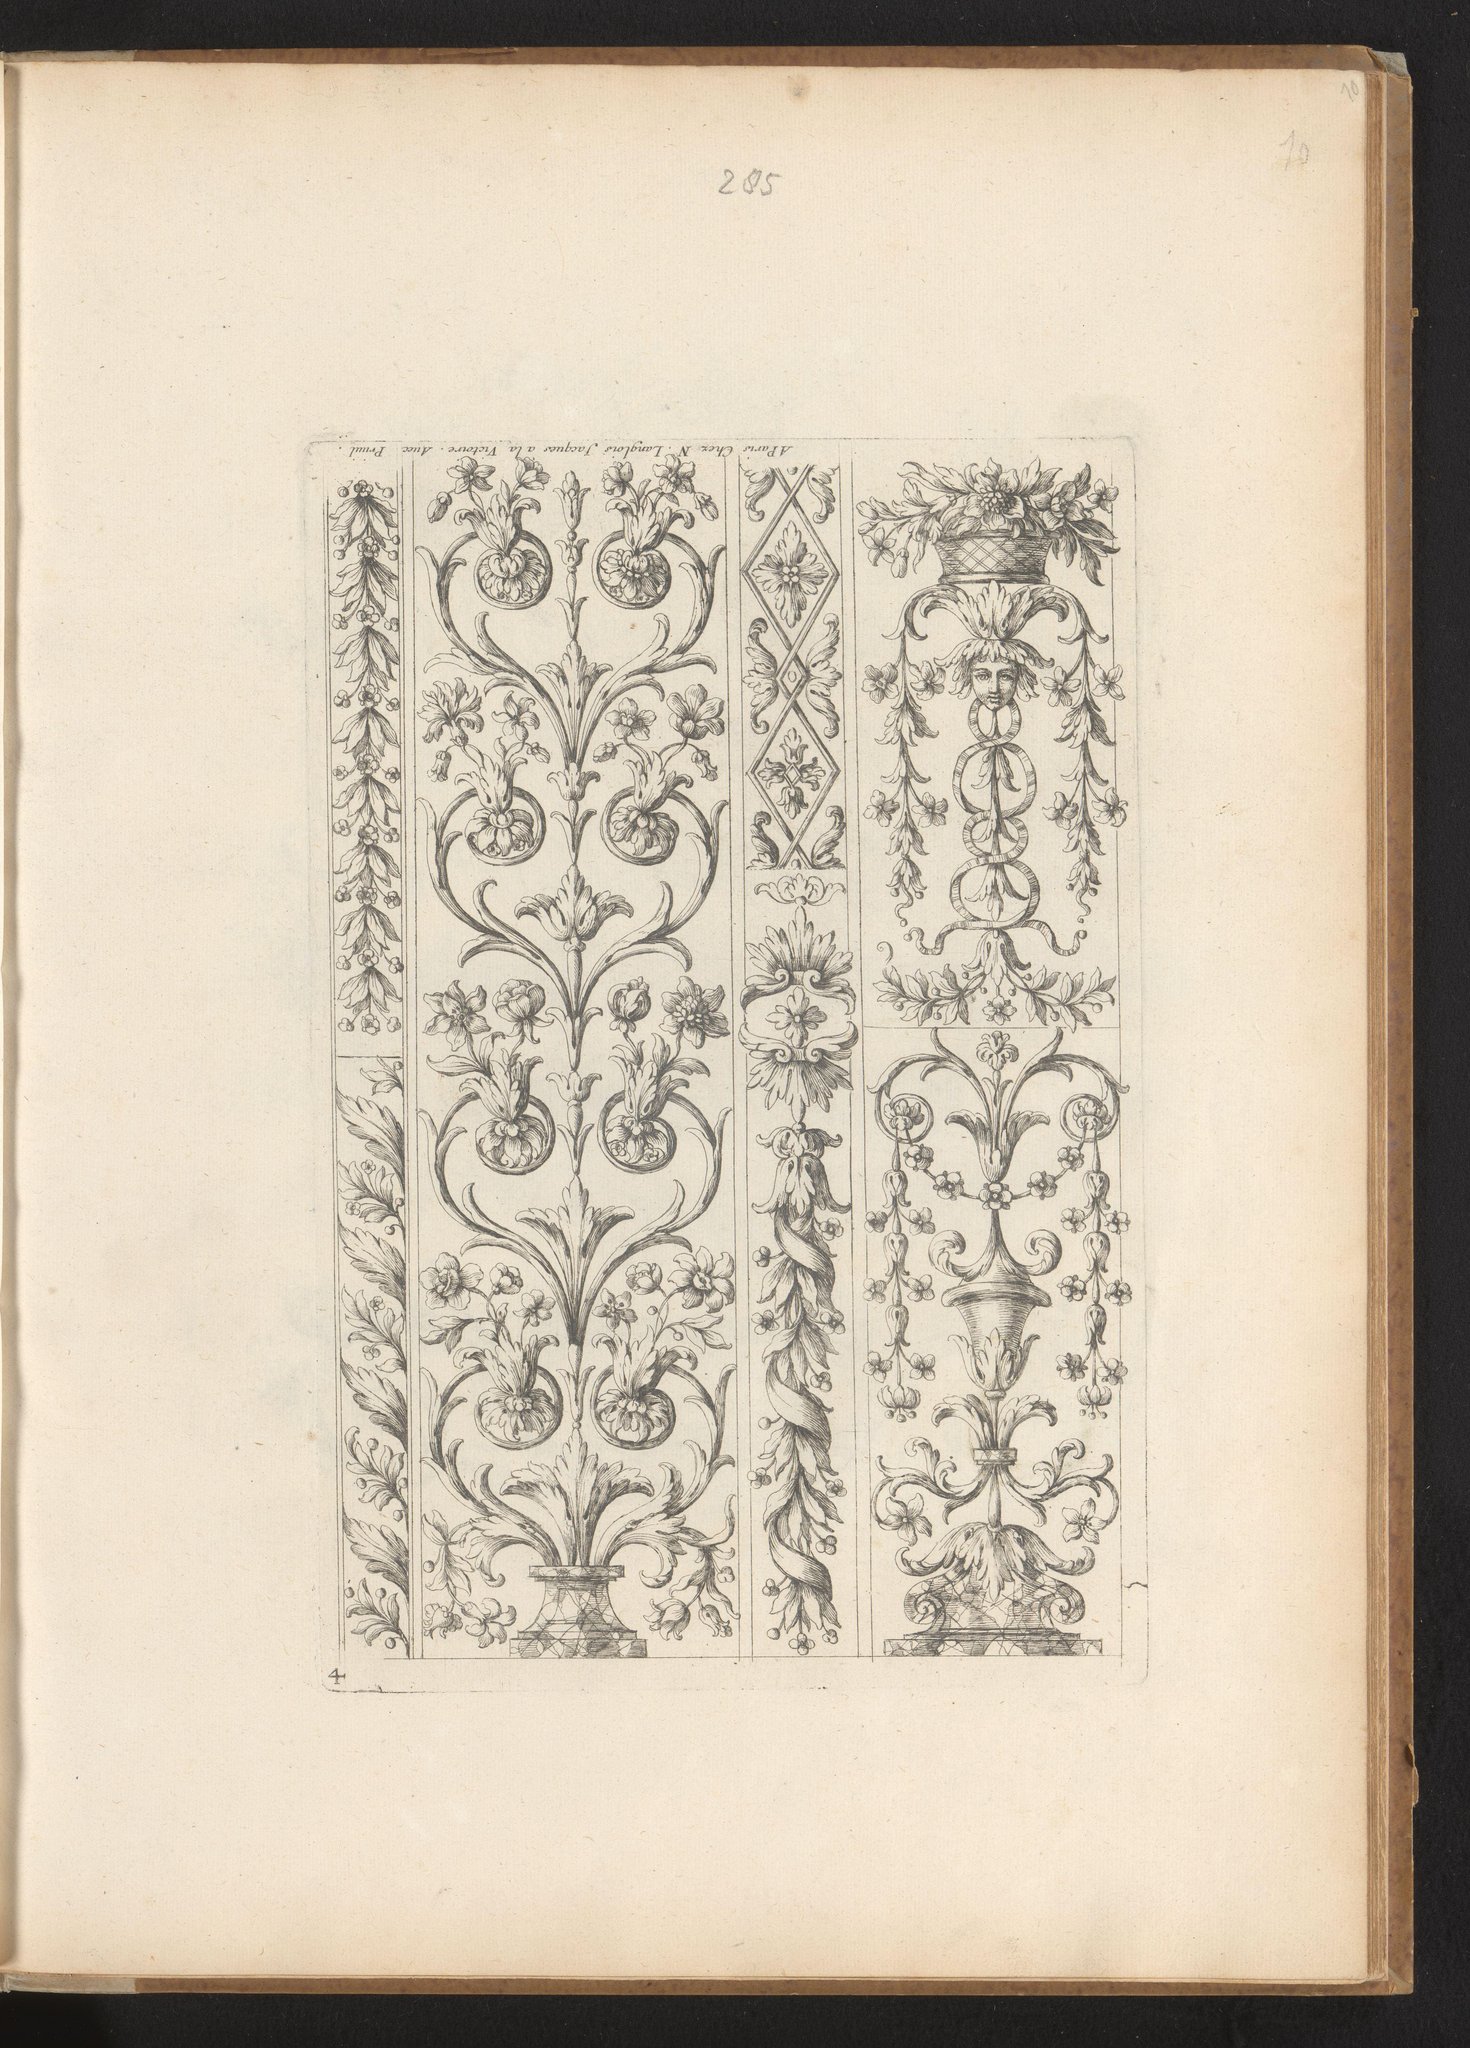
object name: ornament print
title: Ornamentpanelen met acanthusmotieven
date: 1650-1703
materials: paper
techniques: etching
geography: france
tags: ornament ~ candelabrum, flowers ~ ornament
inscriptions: collector's mark: Lugt 2228a, collector's mark: Lugt 2760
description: Deze prent maakt deel uit van een album.